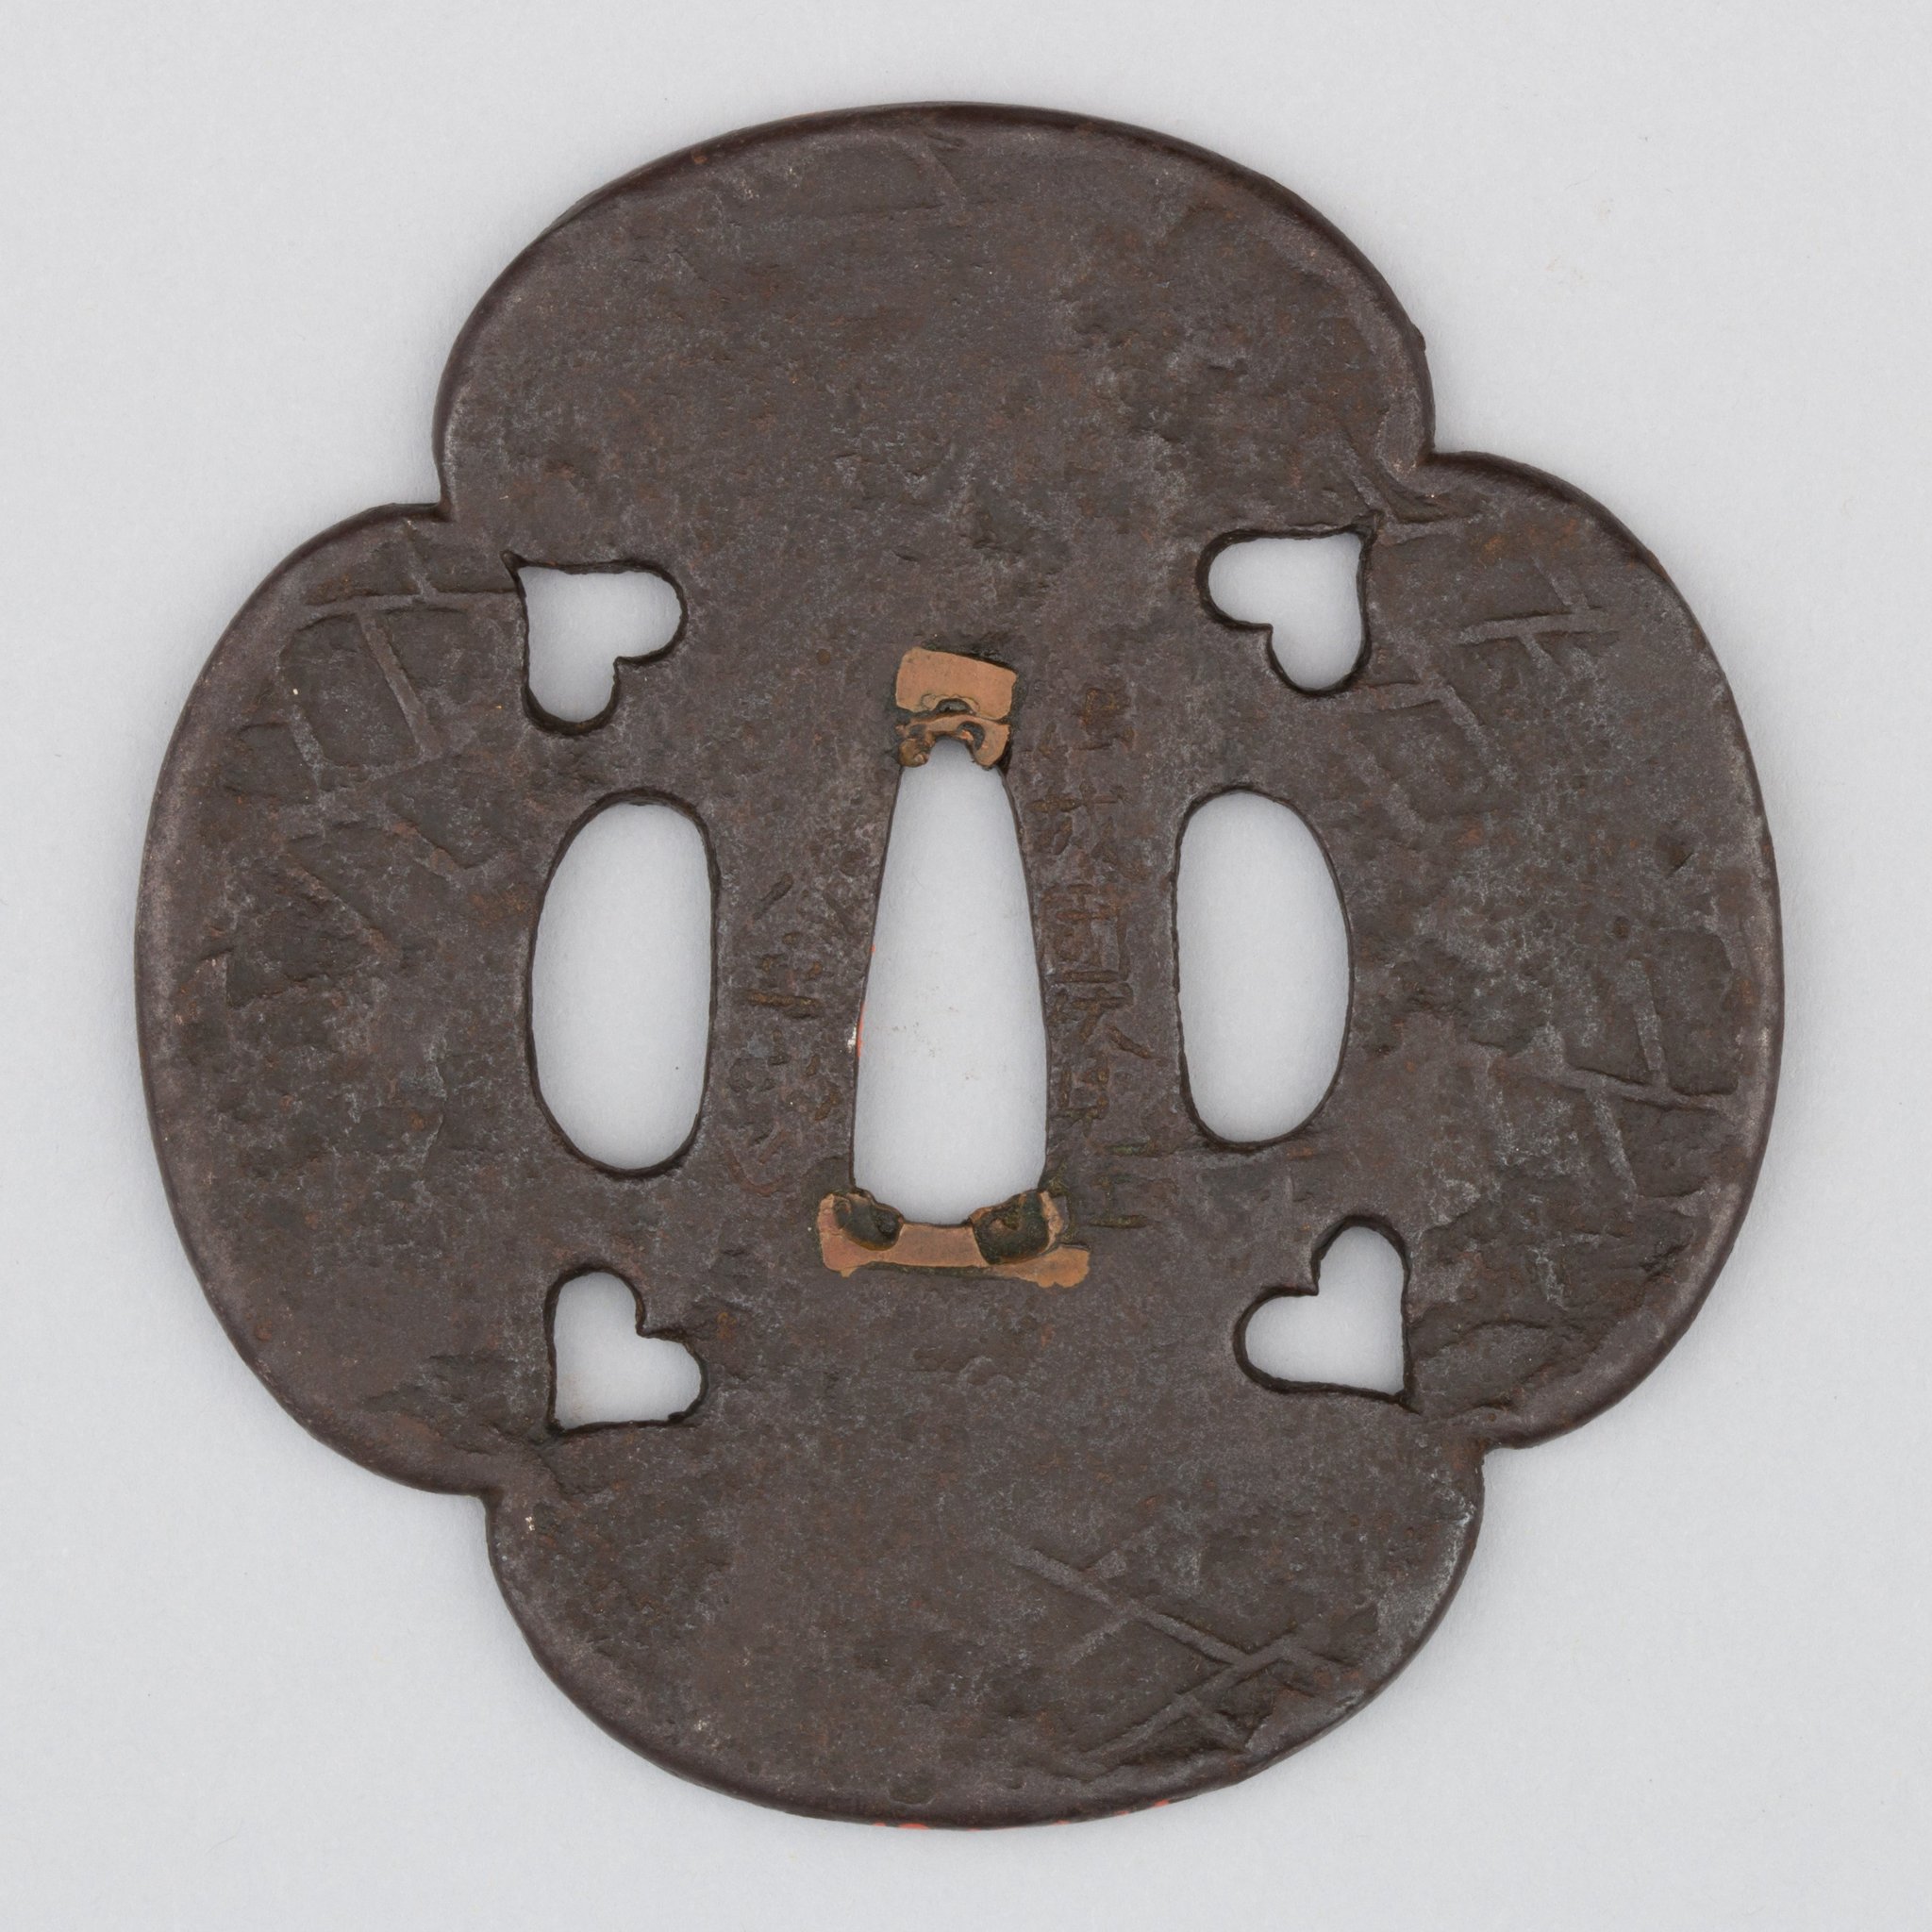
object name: sword guard tsuba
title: Sword Guard (Tsuba)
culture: japanese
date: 1701-1800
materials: copper, iron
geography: japan